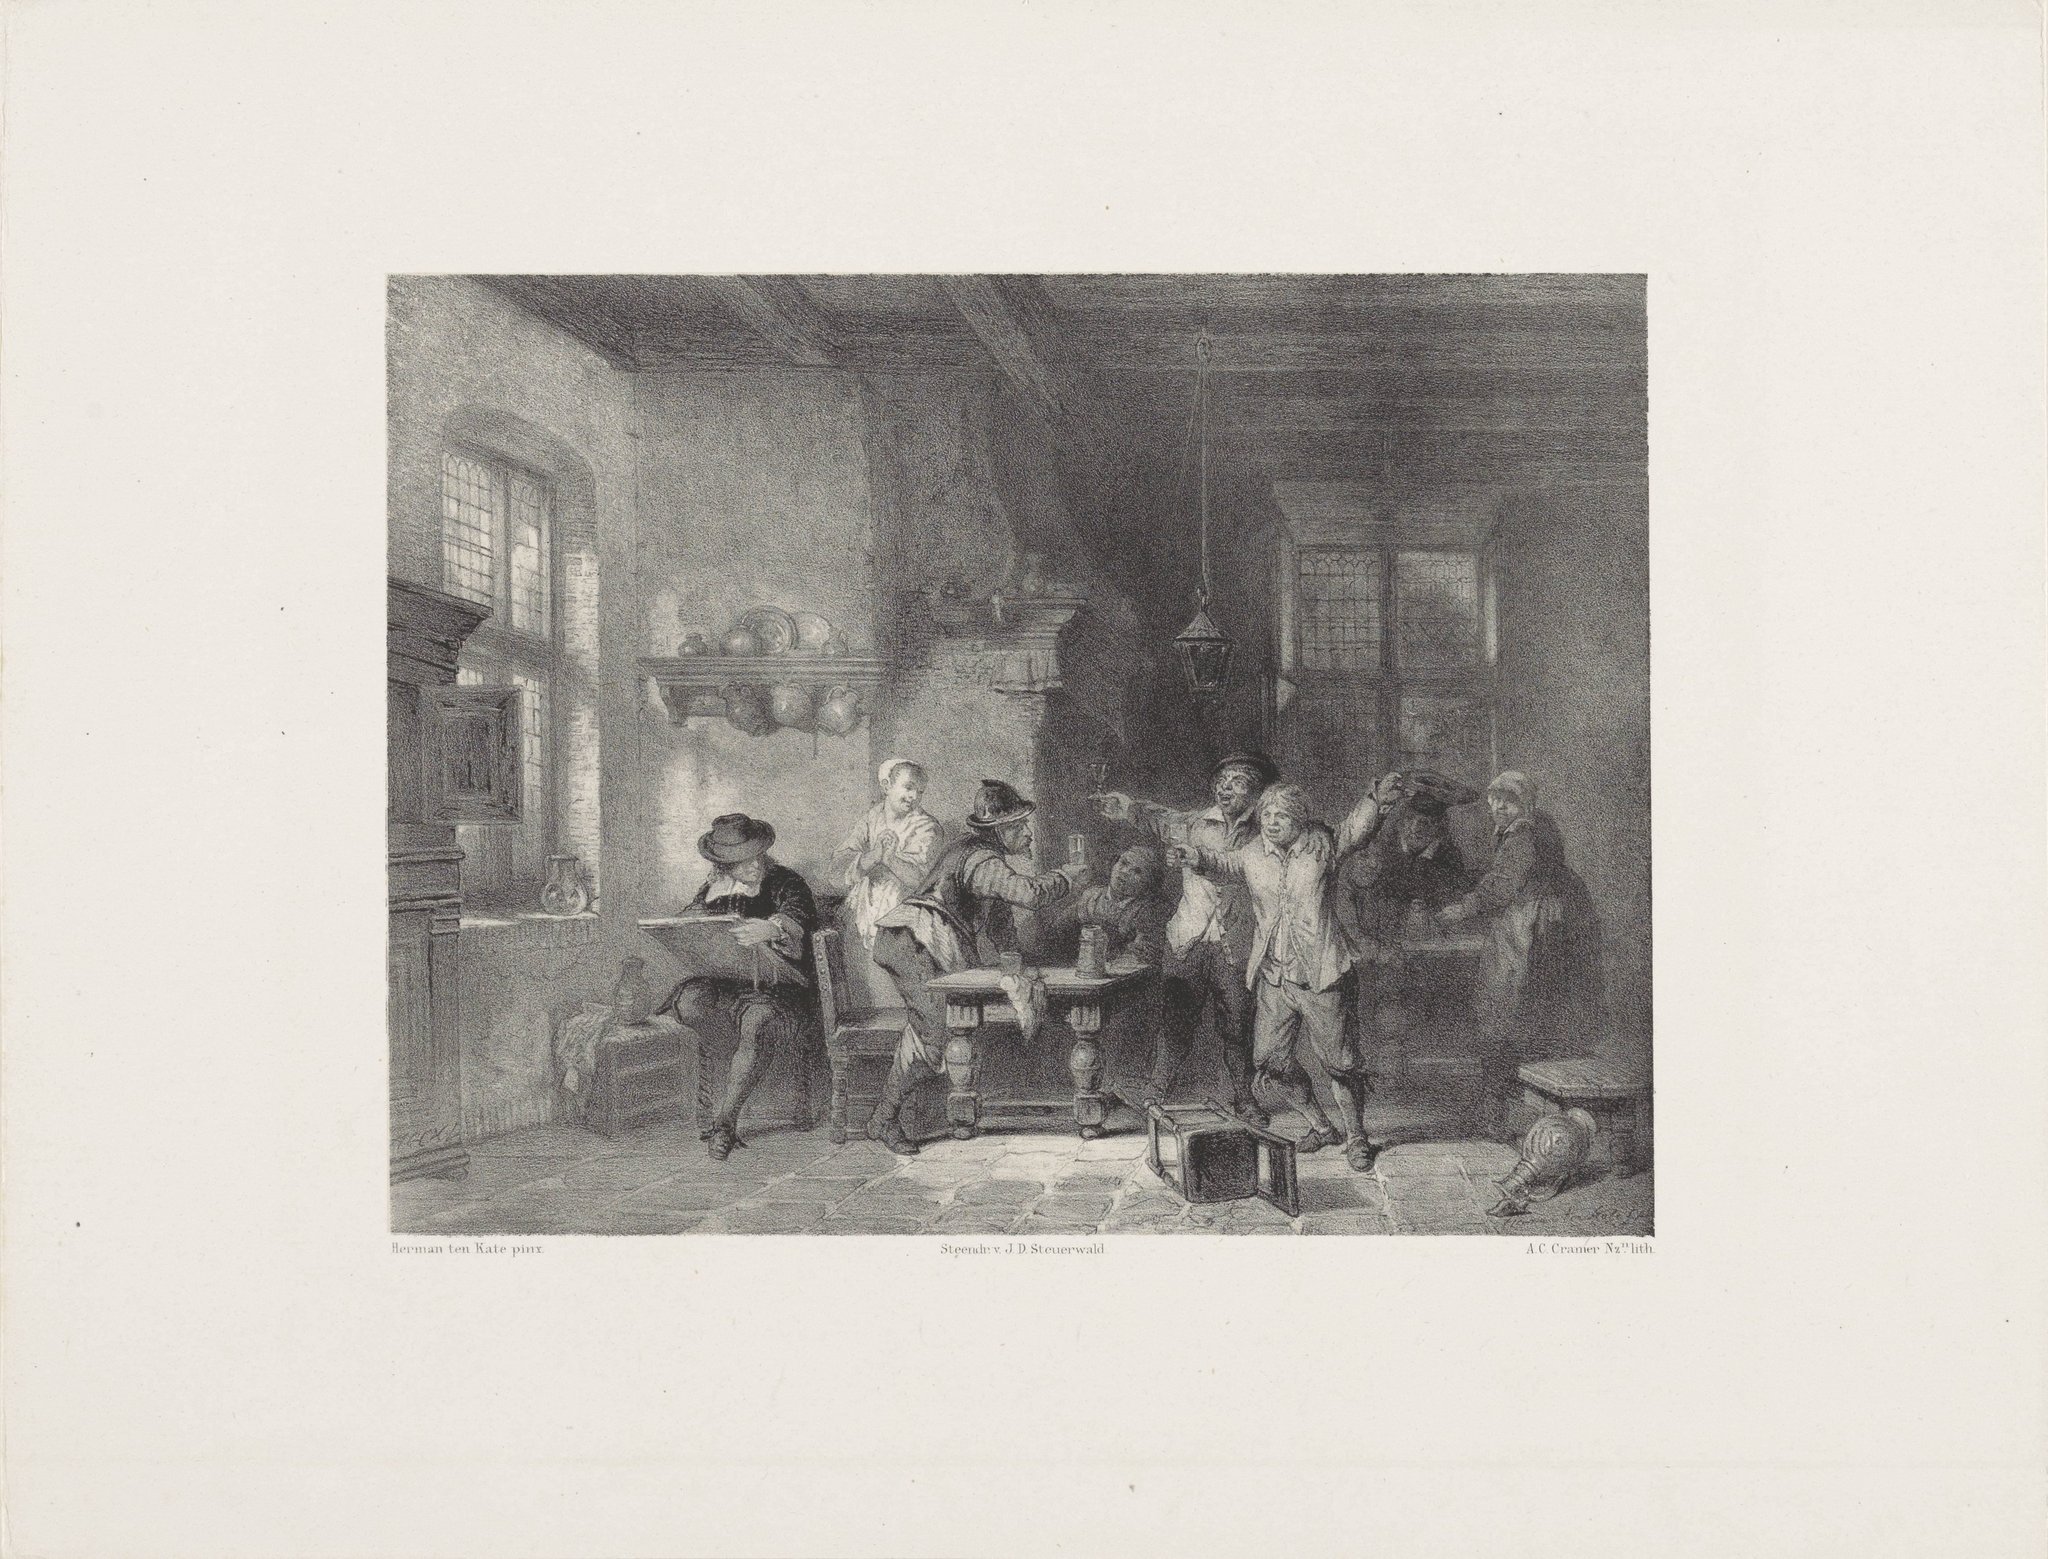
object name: print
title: Herberg met tekenaar en boeren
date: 1852-1863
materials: paper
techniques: lithograph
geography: amsterdam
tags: inn, coffee-house, public house, etc., draughtsman at work, drinking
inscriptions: collector's mark: Lugt 2228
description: Links in de hoek zit een man met een hoed op het tafereel naast zich te tekenen. In het midden van de kamer proost een soldaat met boeren.